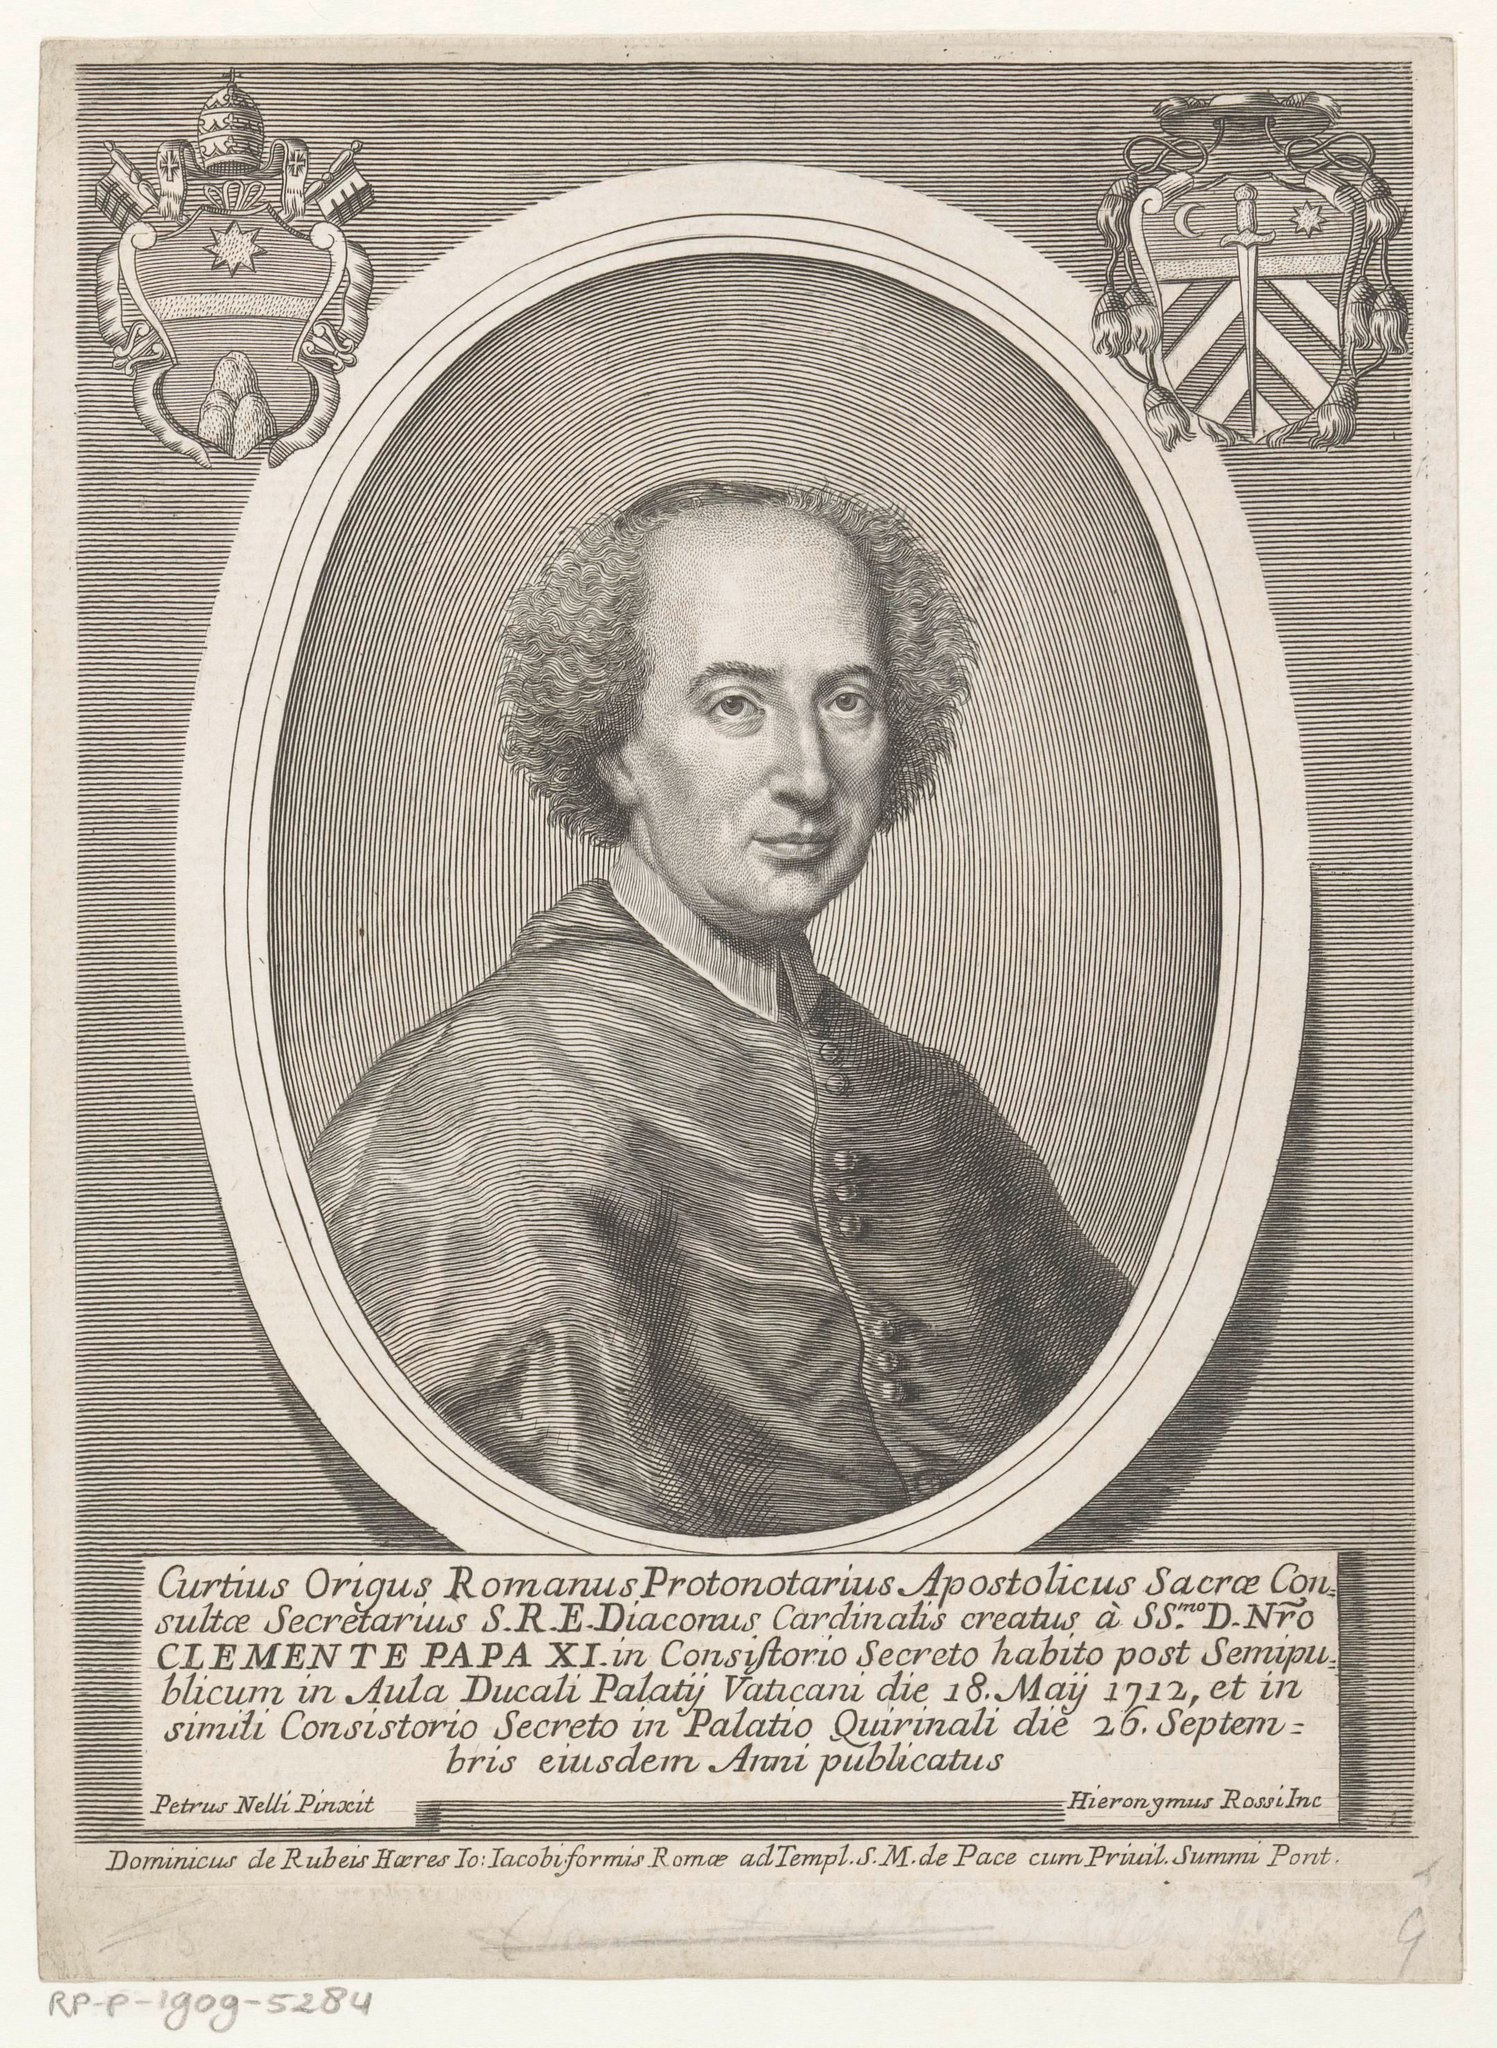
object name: print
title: Portret van kardinaal Curzio Origo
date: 1712-1762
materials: paper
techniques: engraving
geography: italy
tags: cardinal, historical persons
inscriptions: collector's mark: Lugt 2228